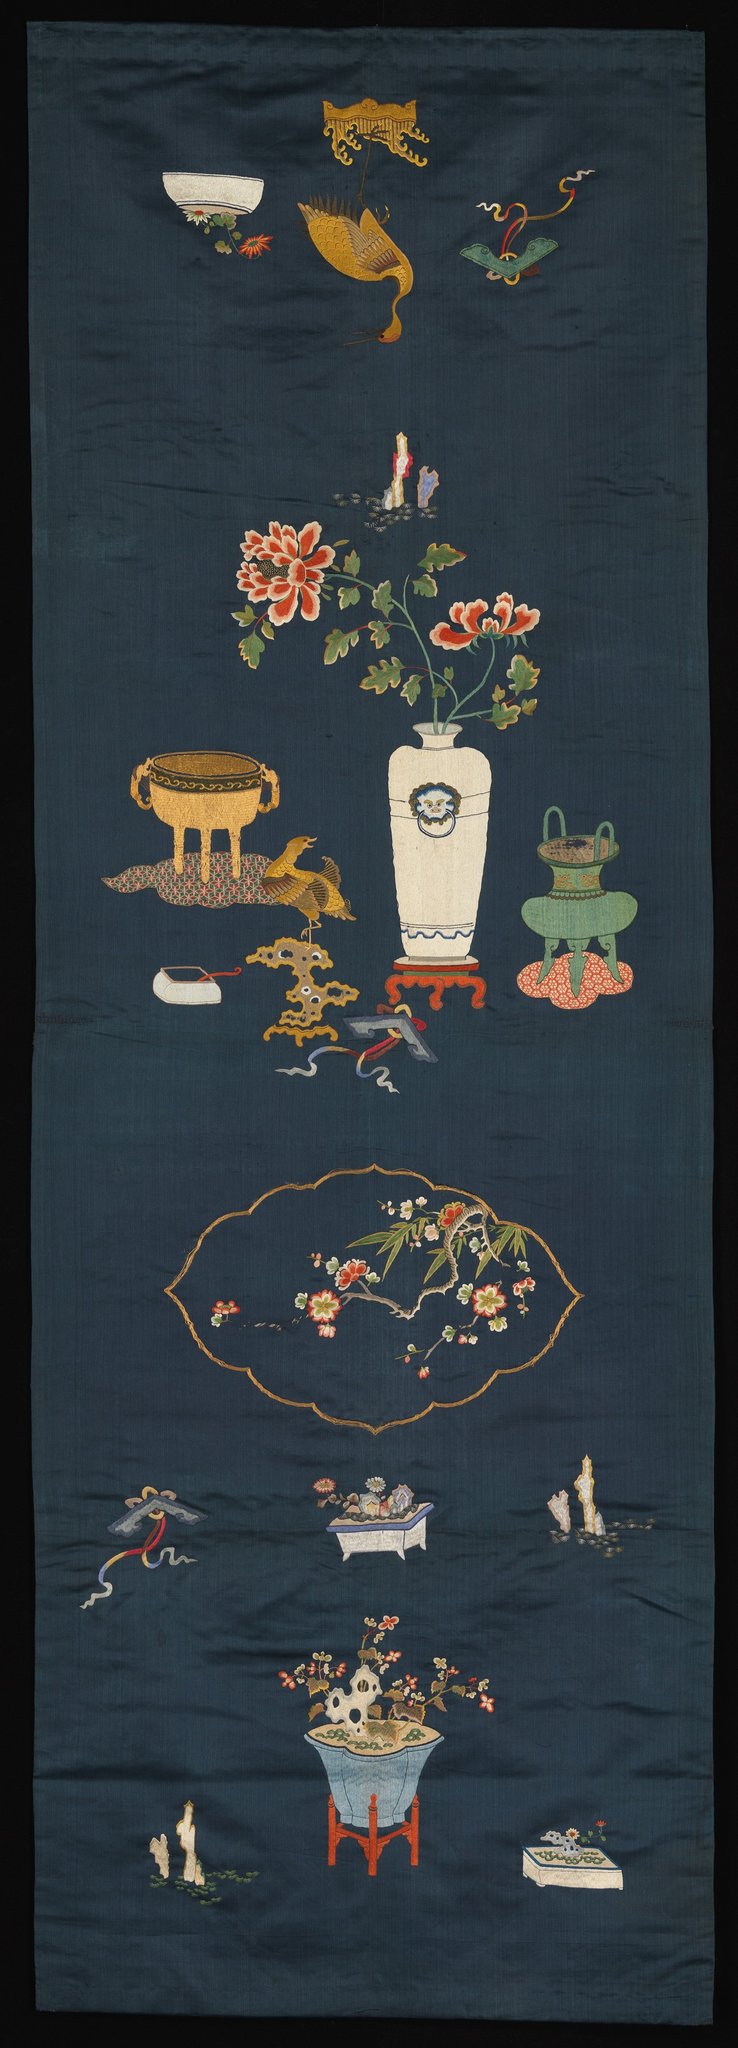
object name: chair strip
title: Chair Strip with Antiquities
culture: chinese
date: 1701-1733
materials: metal thread, silk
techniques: embroidery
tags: ducks,peonies